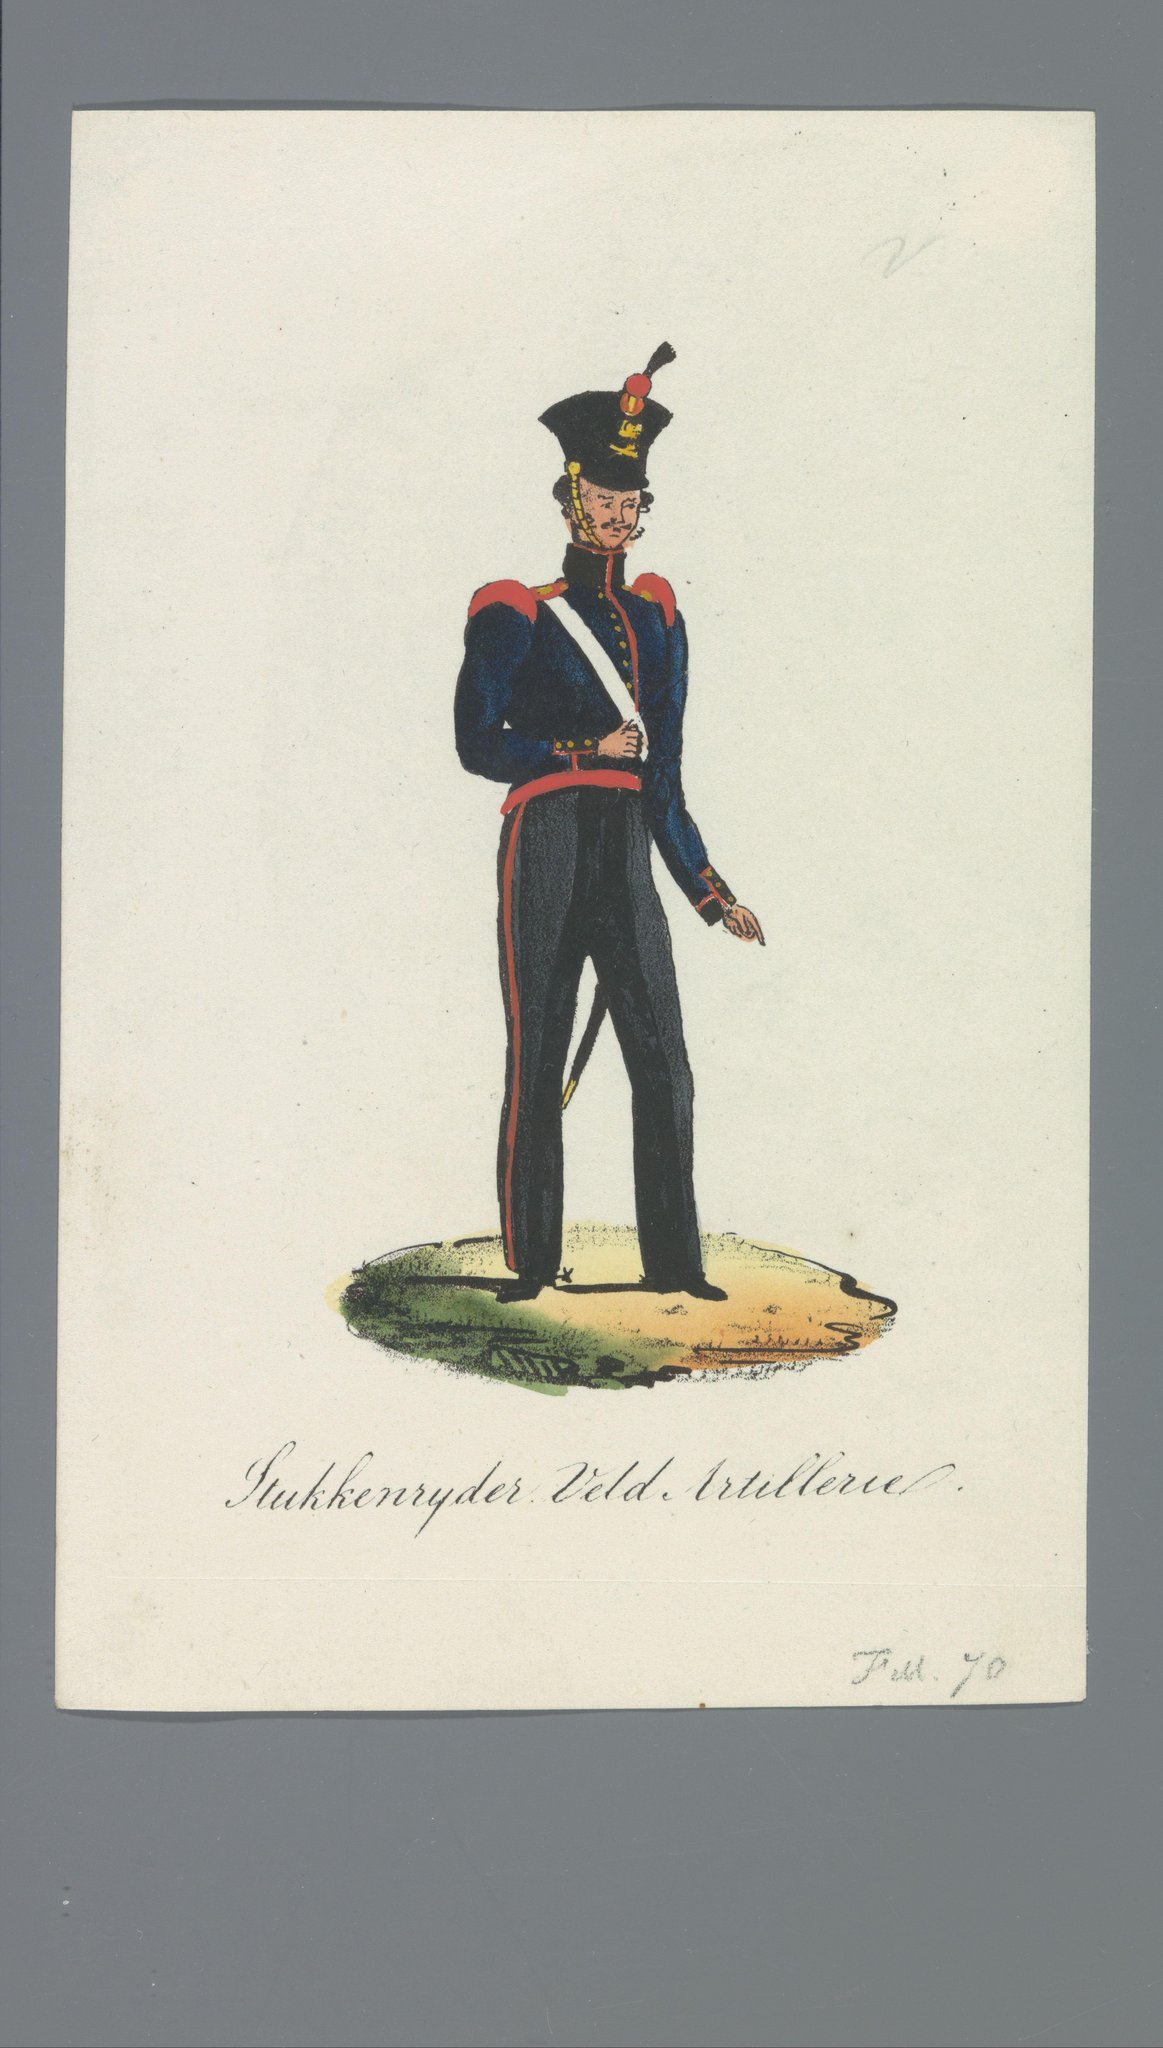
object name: costume print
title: Nederlandse militaire uniformen in de jaren 1830-1832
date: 1835-1850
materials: paper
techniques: hand coloring, lithograph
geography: netherlands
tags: (military) uniforms, clothes, costume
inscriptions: collector's mark: Lugt 2228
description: Een stukkenrijder van de veldartillerie. Onderdeel van een serie van 157 losse bladen met Nederlandse militaire uniformen in de jaren 1830-1832.